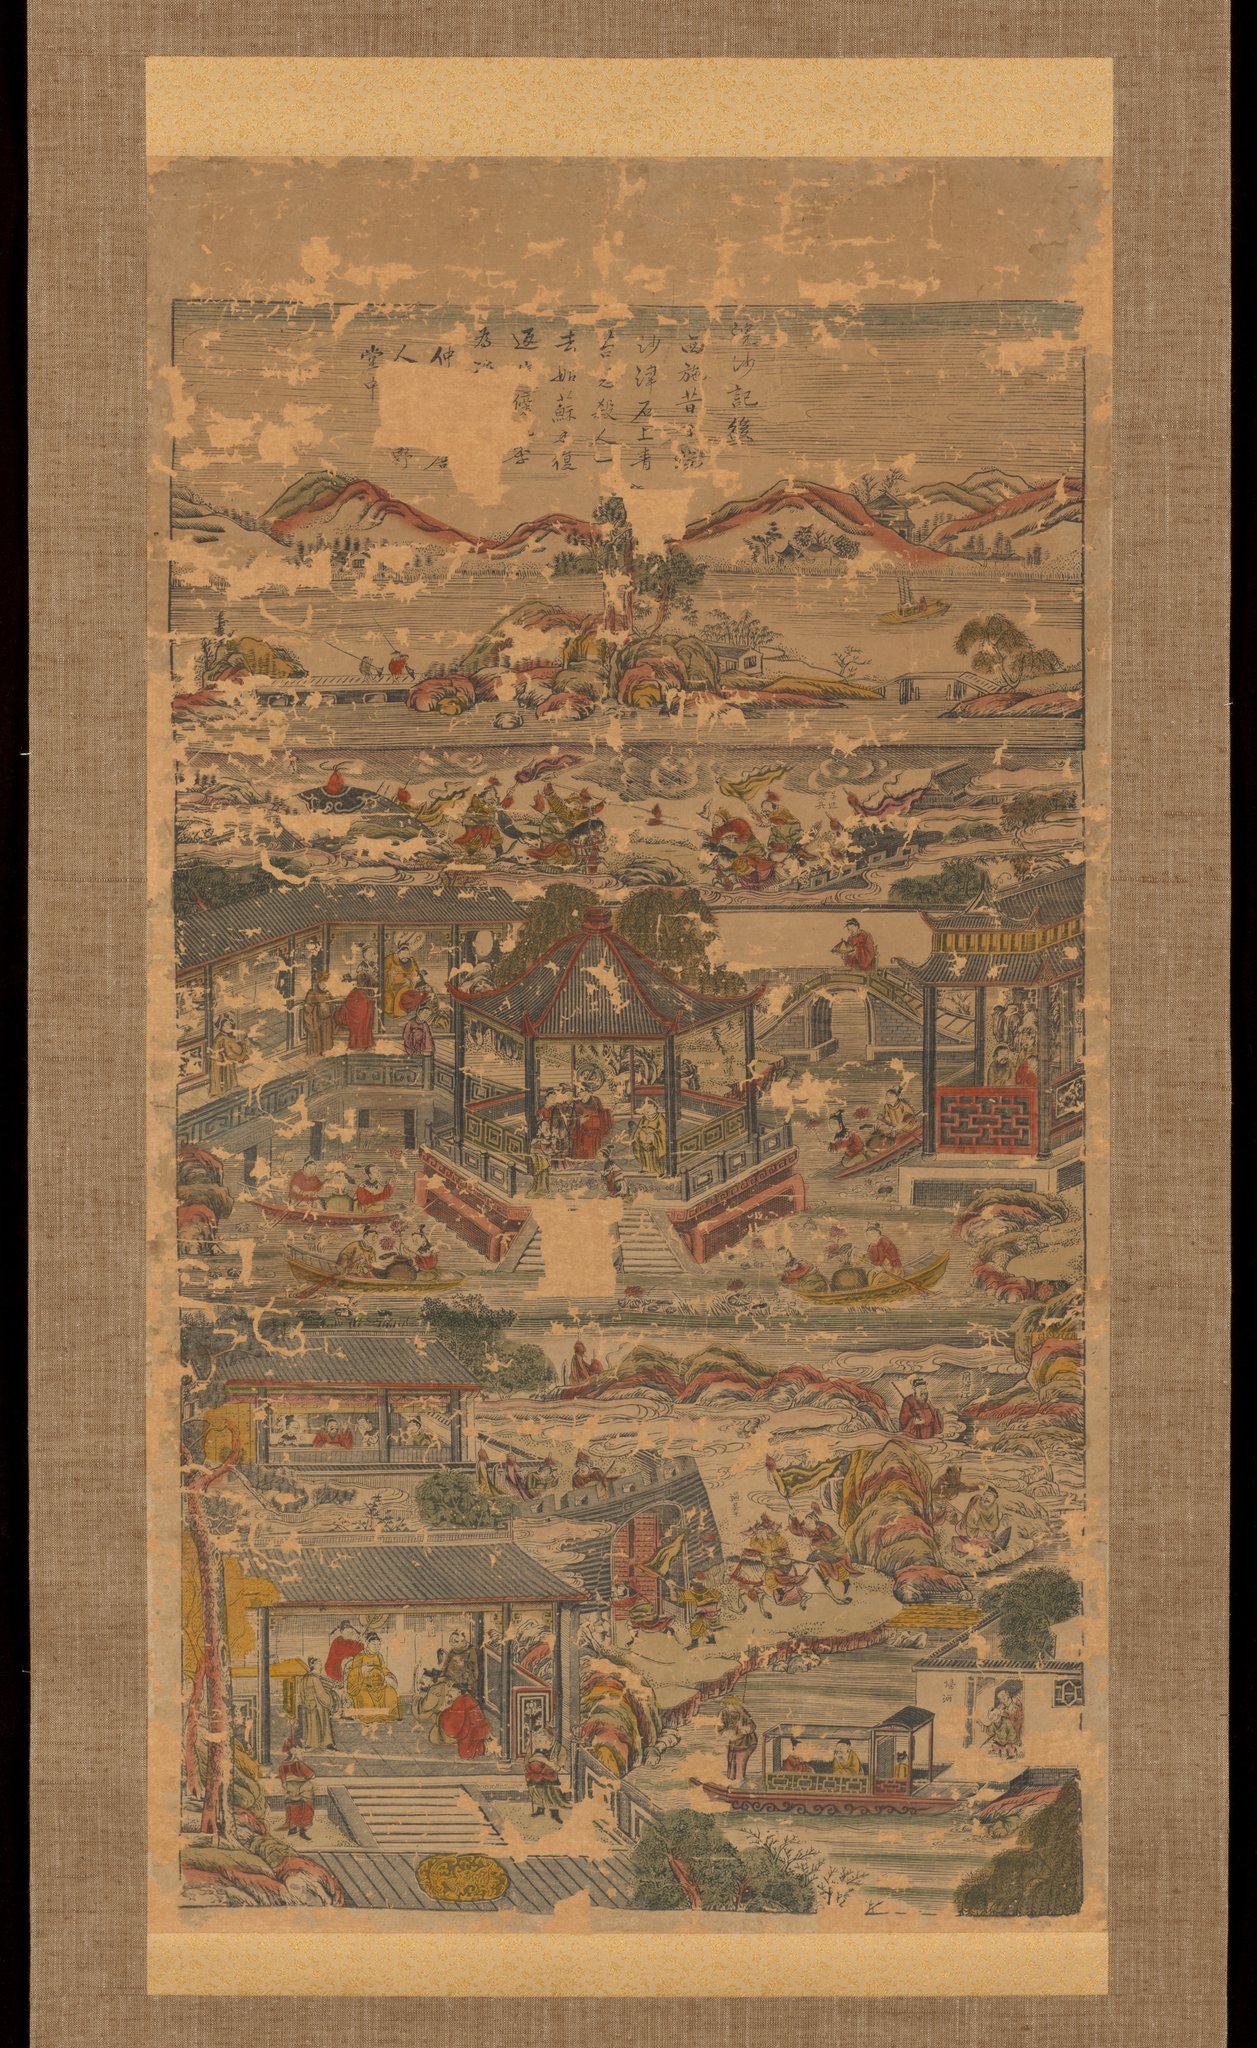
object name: print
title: Second Part of Tale of Washing the Silken Gauze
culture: chinese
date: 1736-1795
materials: ink, paper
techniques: hand coloring, woodblock print